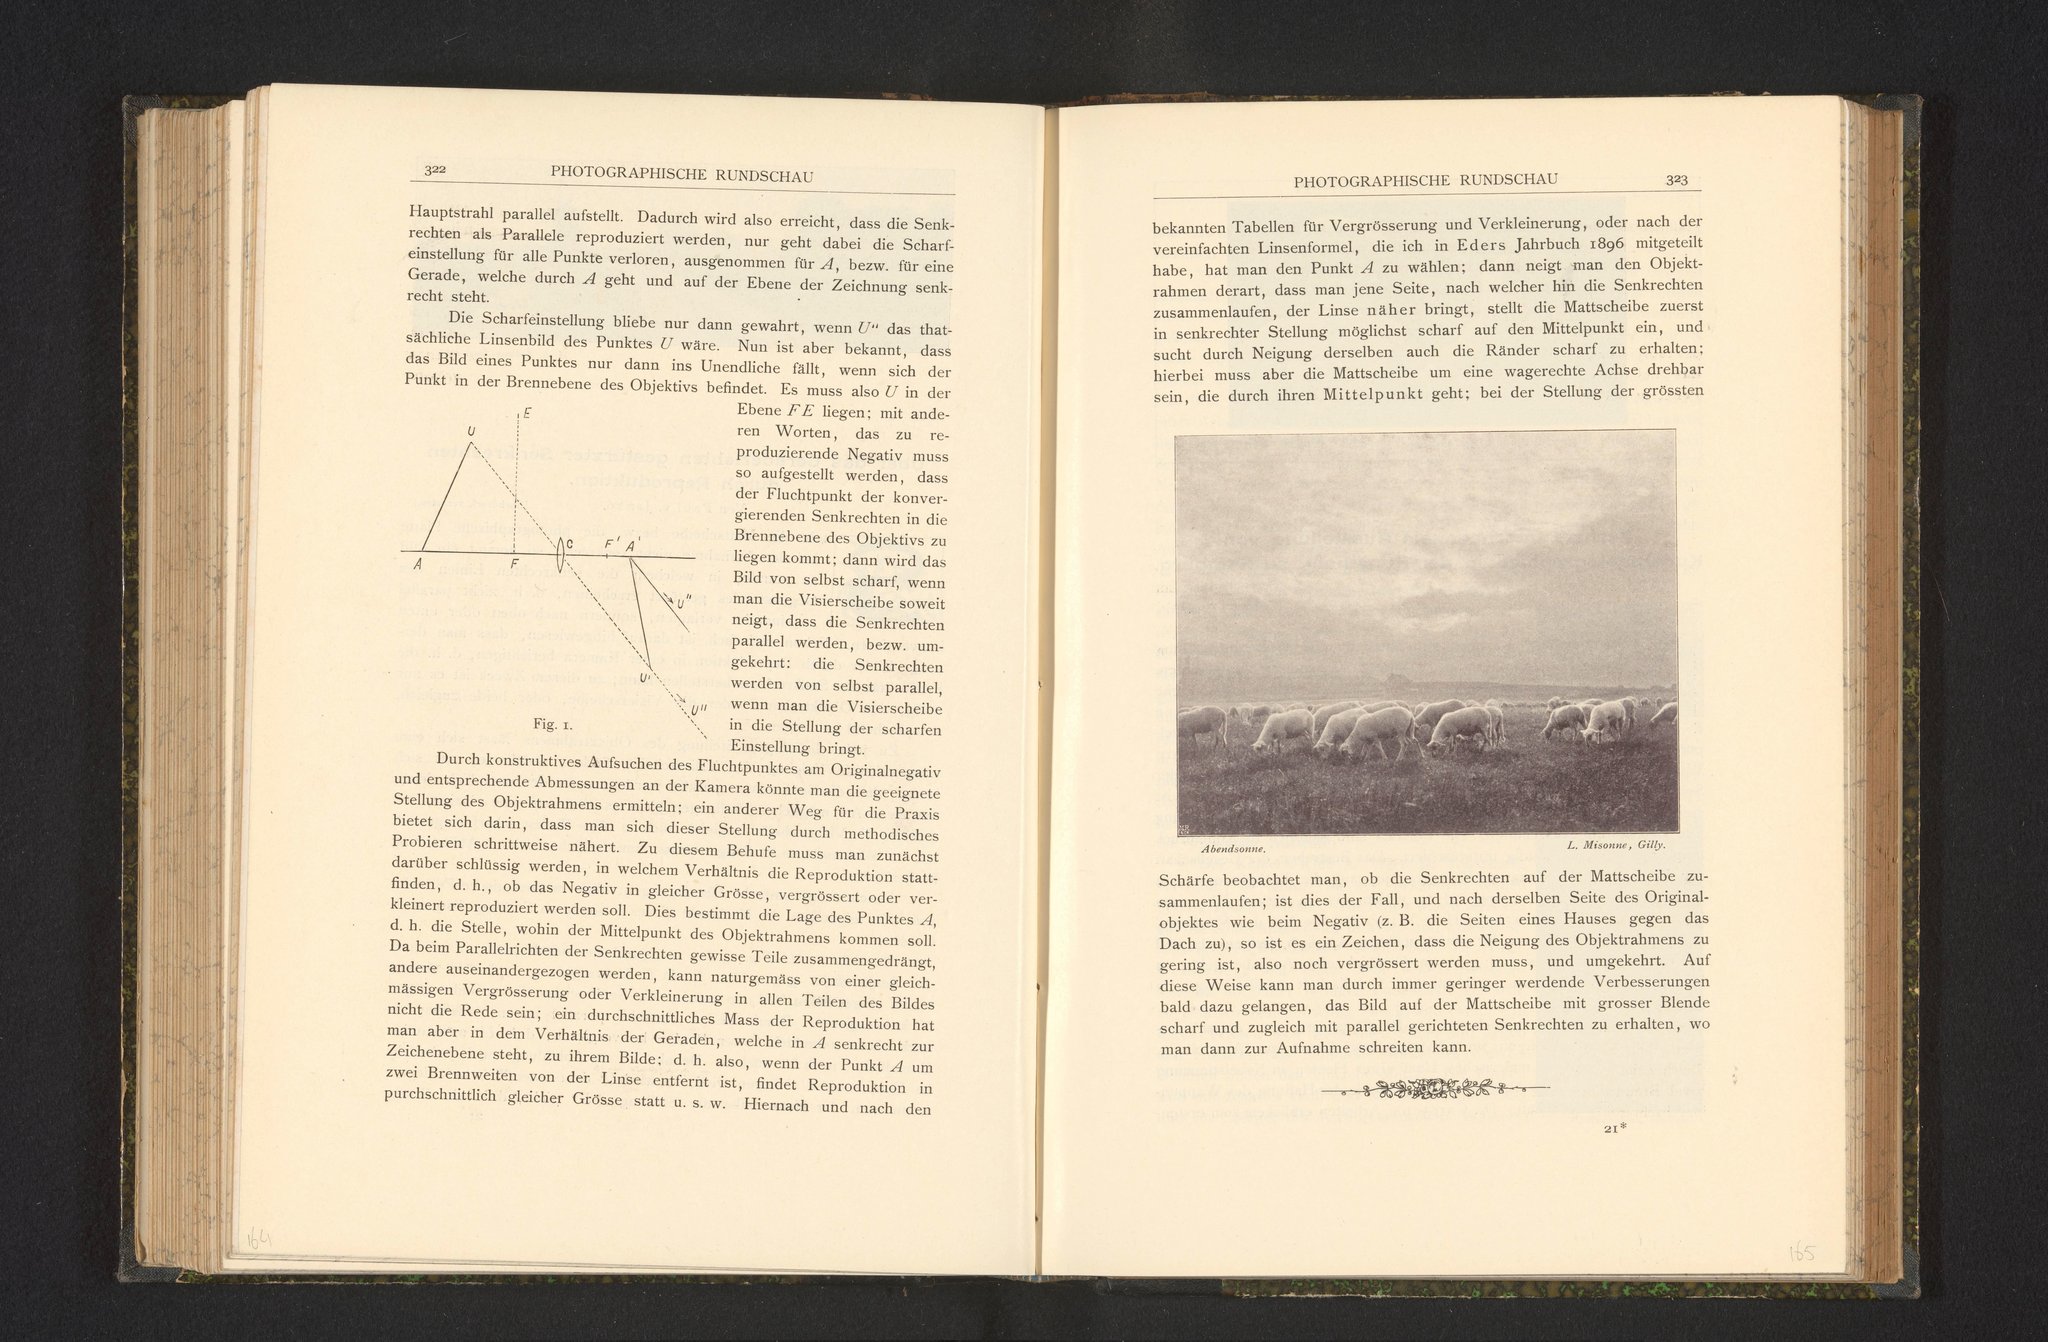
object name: page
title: Gezicht op een kudde schapen op een weiland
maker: léonard misonne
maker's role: fotograaf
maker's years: 1870-1943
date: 1893-1898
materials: paper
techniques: autotype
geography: berlin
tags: meadow, pasture, sheep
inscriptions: monogram: ‘MR/ &Co’